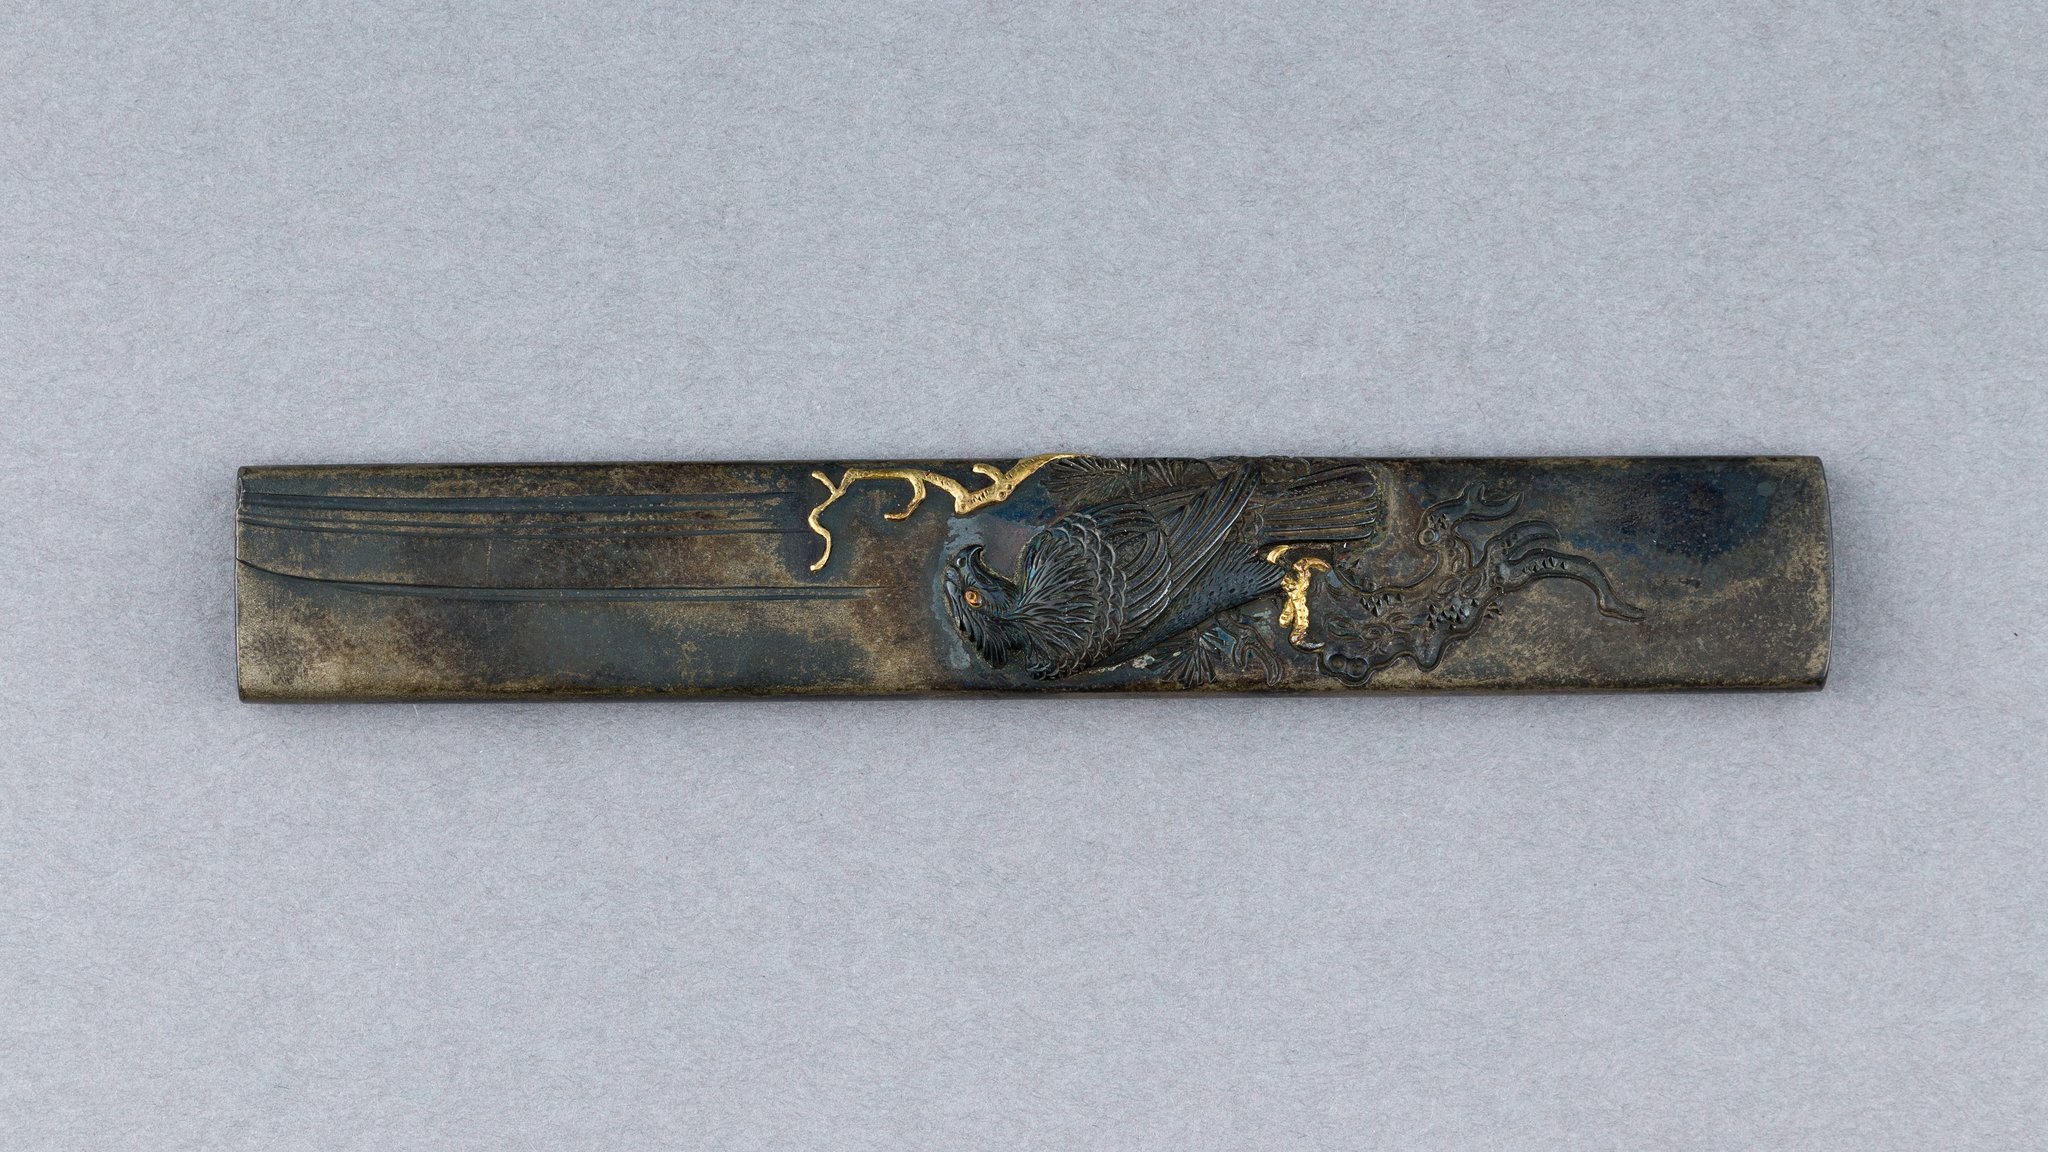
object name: knife handle kozuka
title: Knife Handle (Kozuka)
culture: japanese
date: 1615-1868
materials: gold alloy, silver alloy, gold, silver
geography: japan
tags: birds